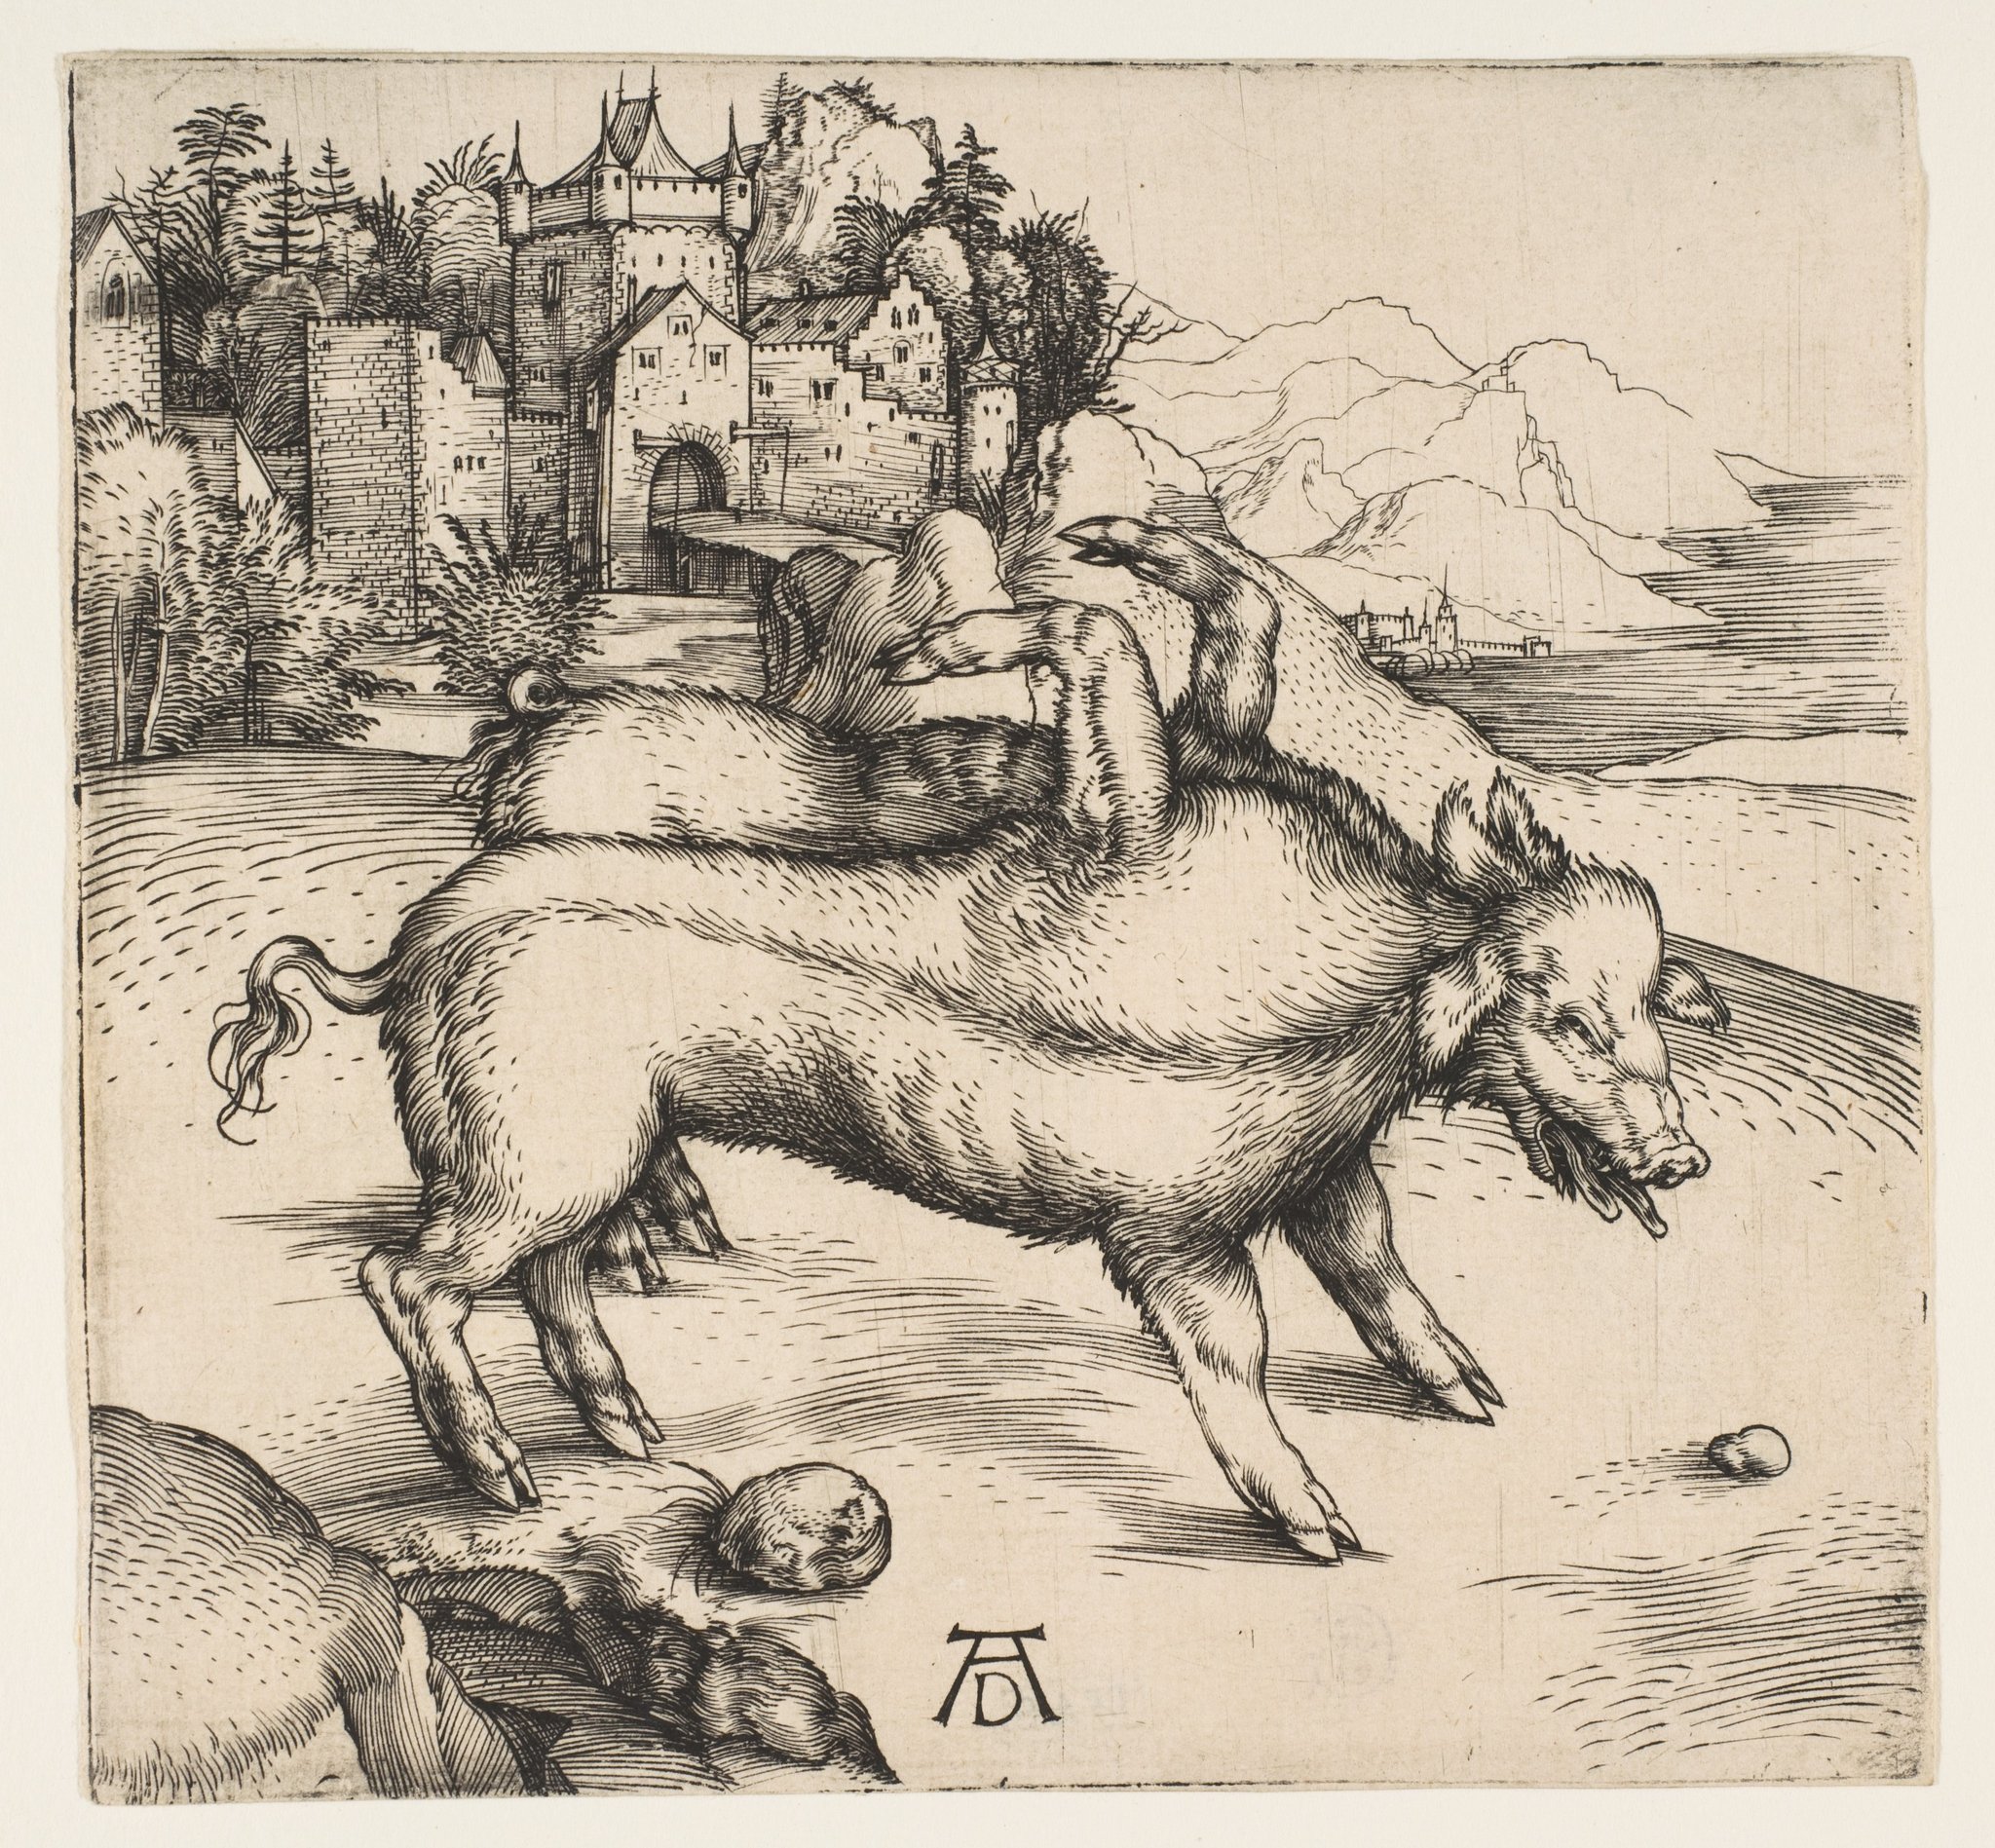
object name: print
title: The Monstrous Pig of Landser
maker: albrecht dürer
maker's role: artist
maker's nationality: german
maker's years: 1471-1528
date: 1496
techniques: engraving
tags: pigs